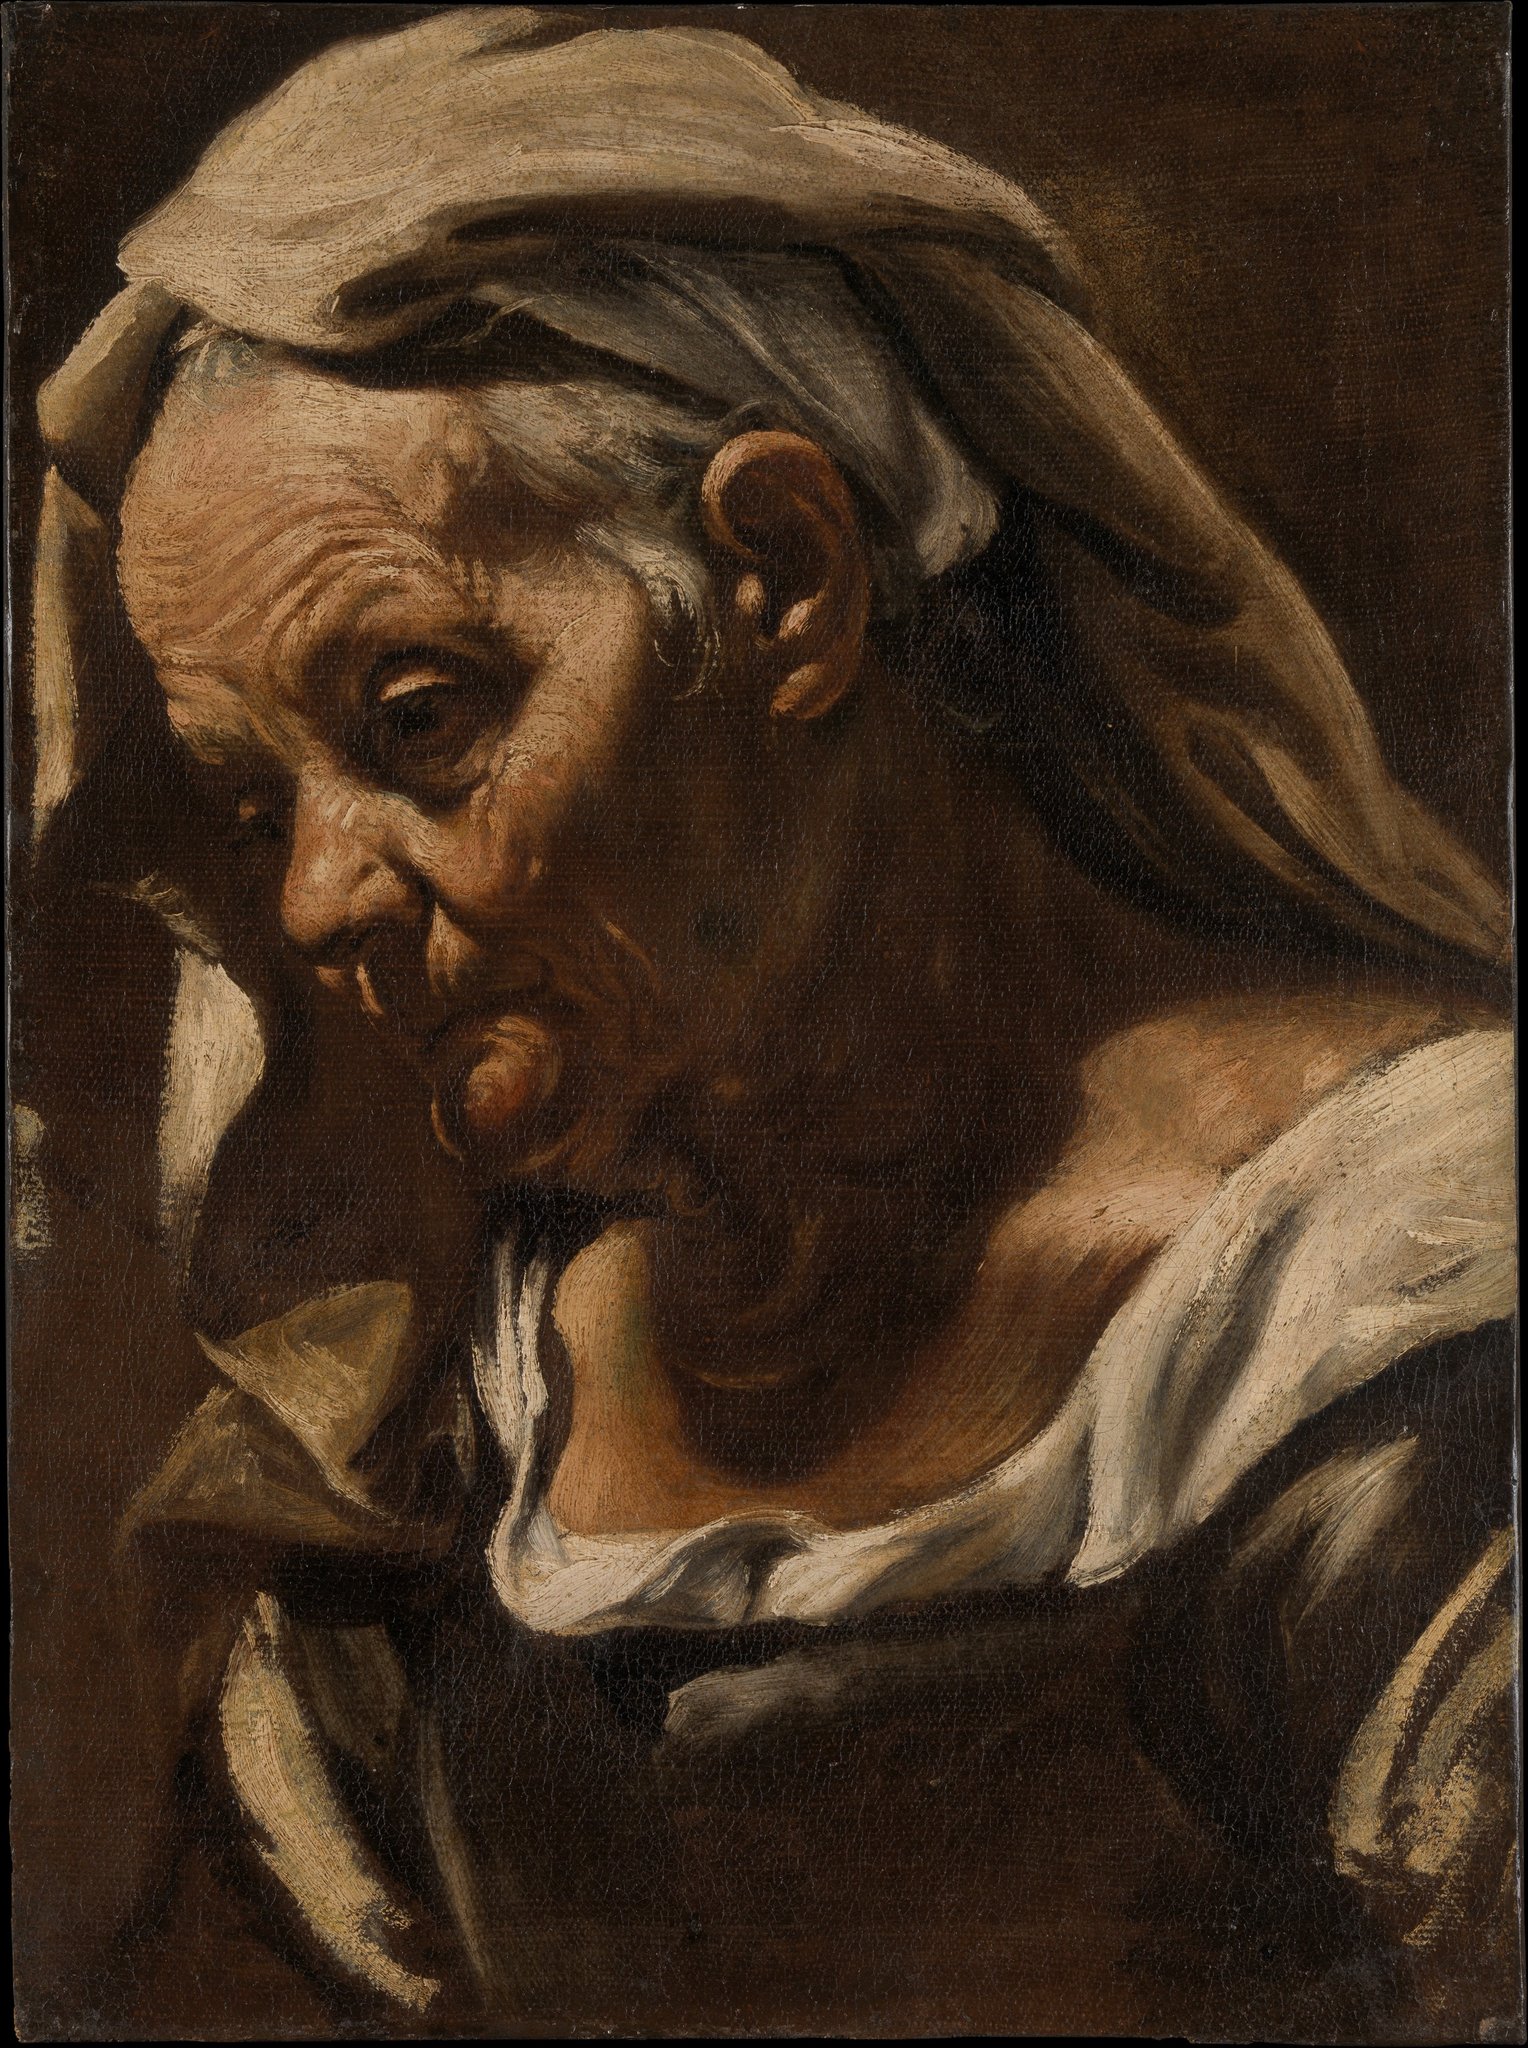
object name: painting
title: Head of an Old Woman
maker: orazio borgianni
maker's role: artist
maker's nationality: italian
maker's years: 1578-1616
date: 1610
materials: canvas, oil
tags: heads,portraits,women